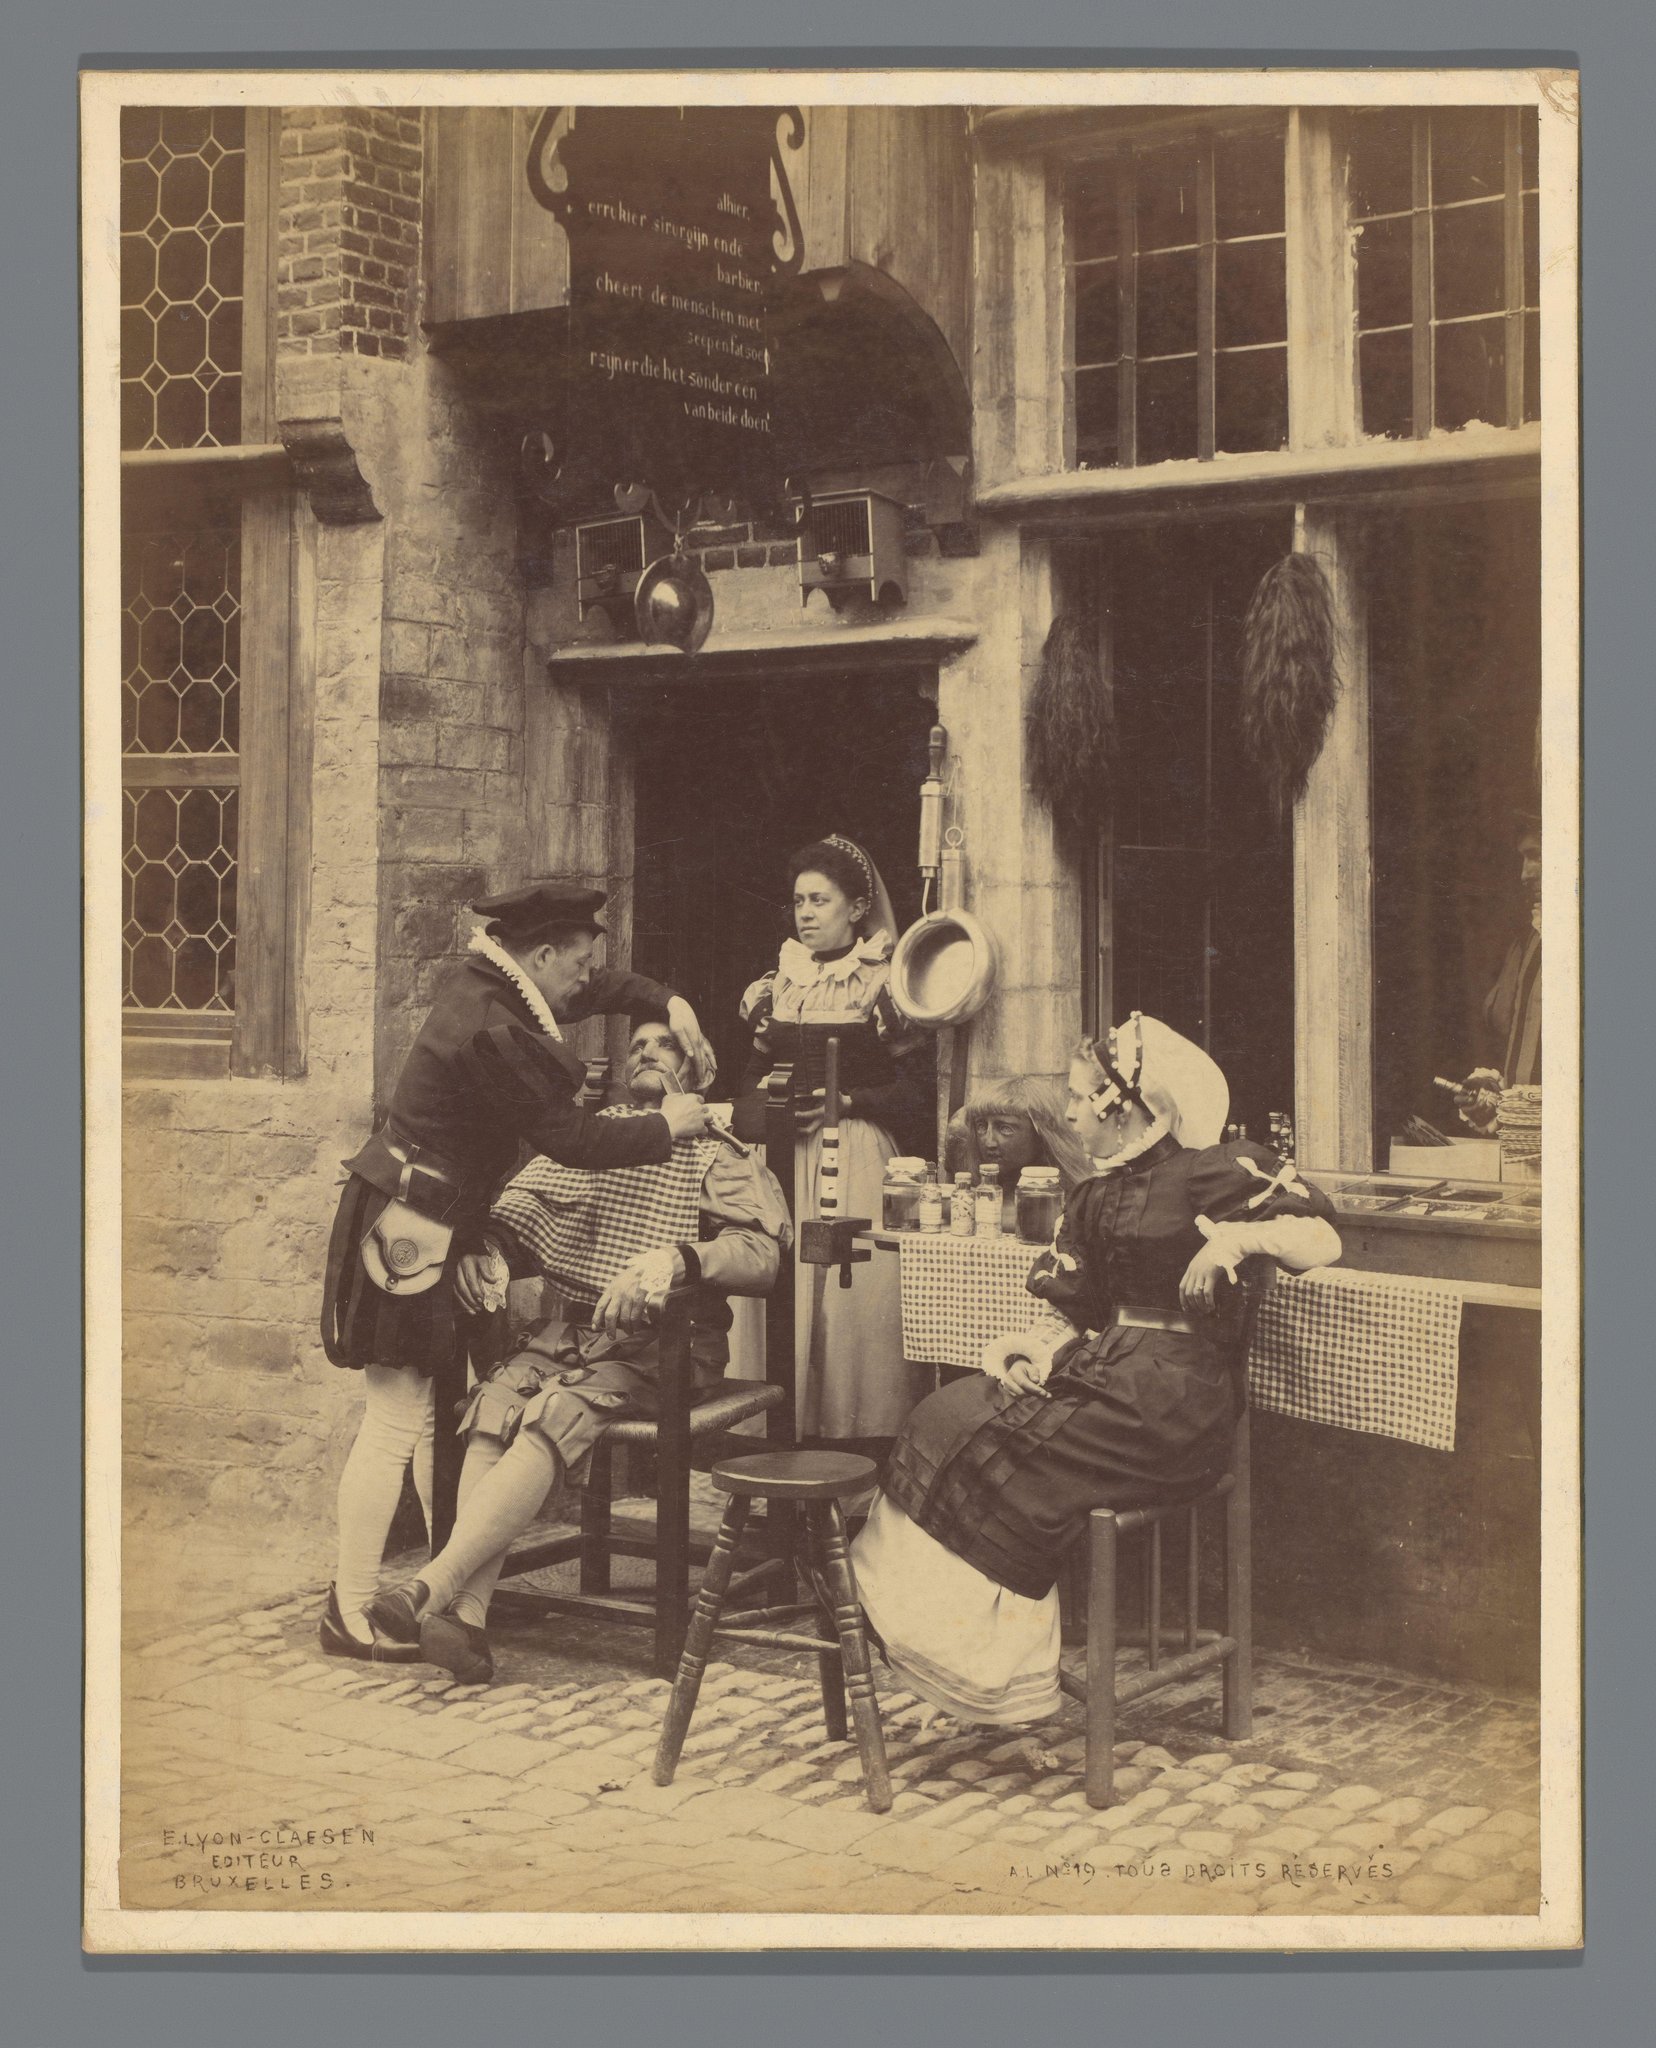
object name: photograph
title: Kostuumschouwspel met een kapper ter gelegenheid van de Wereldtentoonstelling van 1894 in Antwerpen, België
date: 1894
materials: cardboard, paper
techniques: albumen print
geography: brussels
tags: historical costume, antwerp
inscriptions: number: ‘No 19’, inscription: ‘TOUS DROITS RÉSERVÉS’